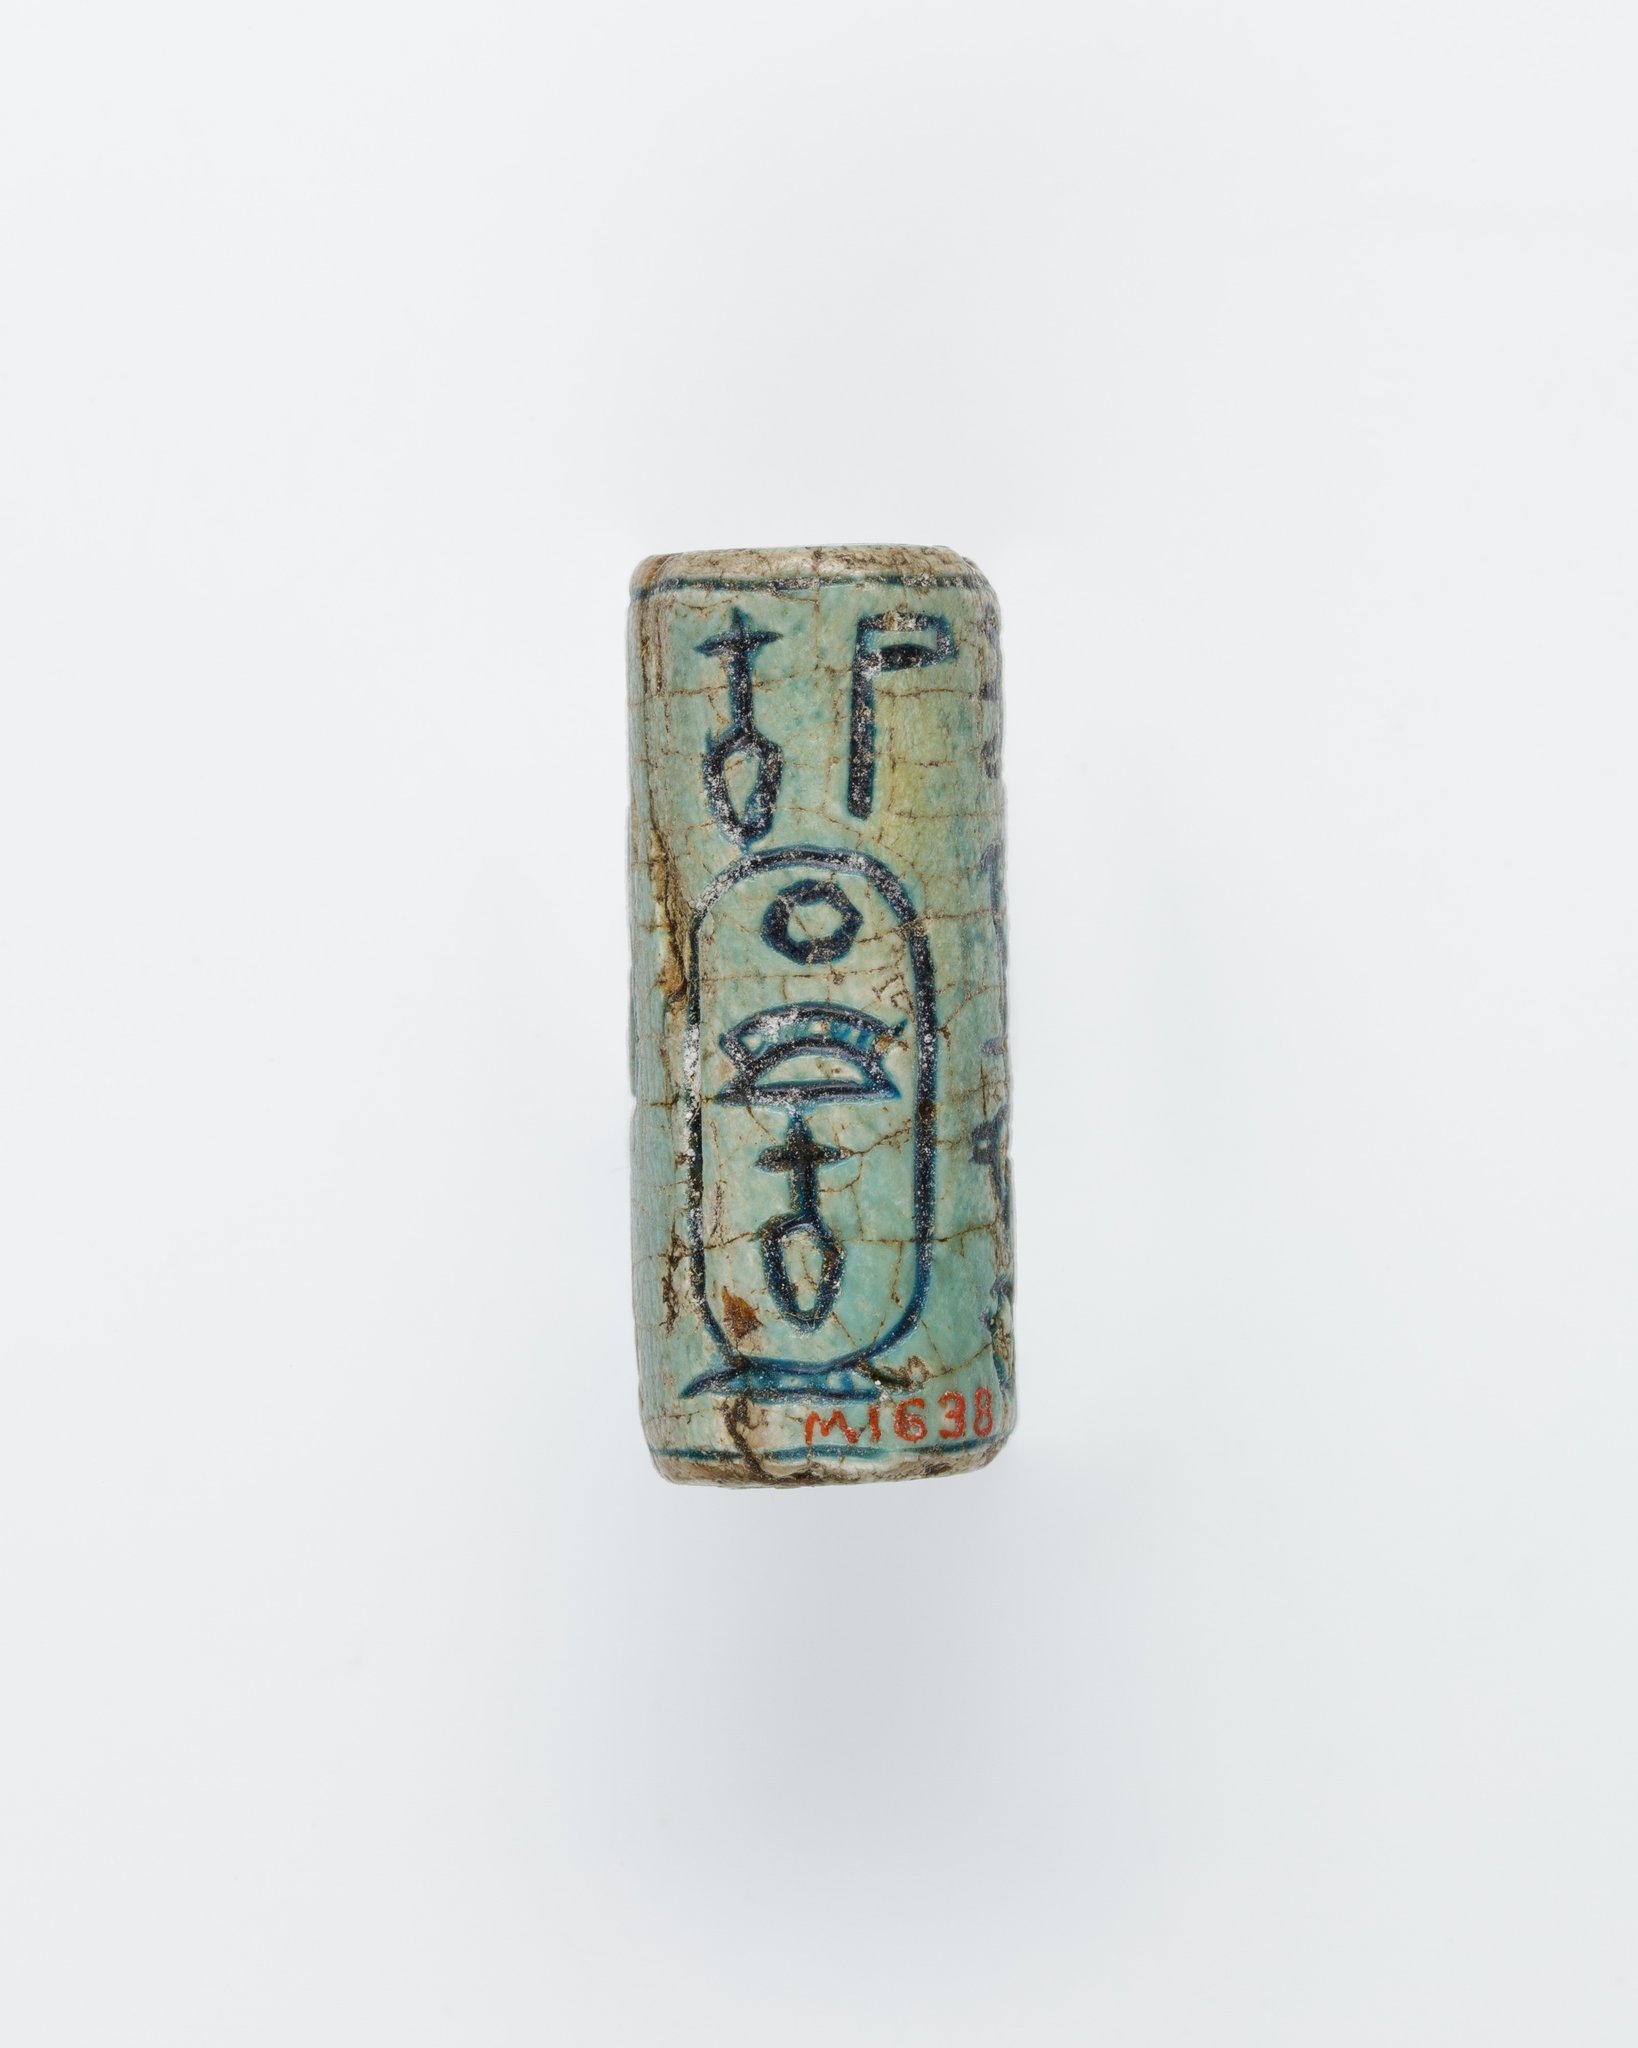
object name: cylinder seal inscribed sobekhotep iii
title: Cylinder seal inscribed for Khaneferre Sobekhotep III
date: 1640-1550 BCE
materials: stone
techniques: glazing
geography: egypt